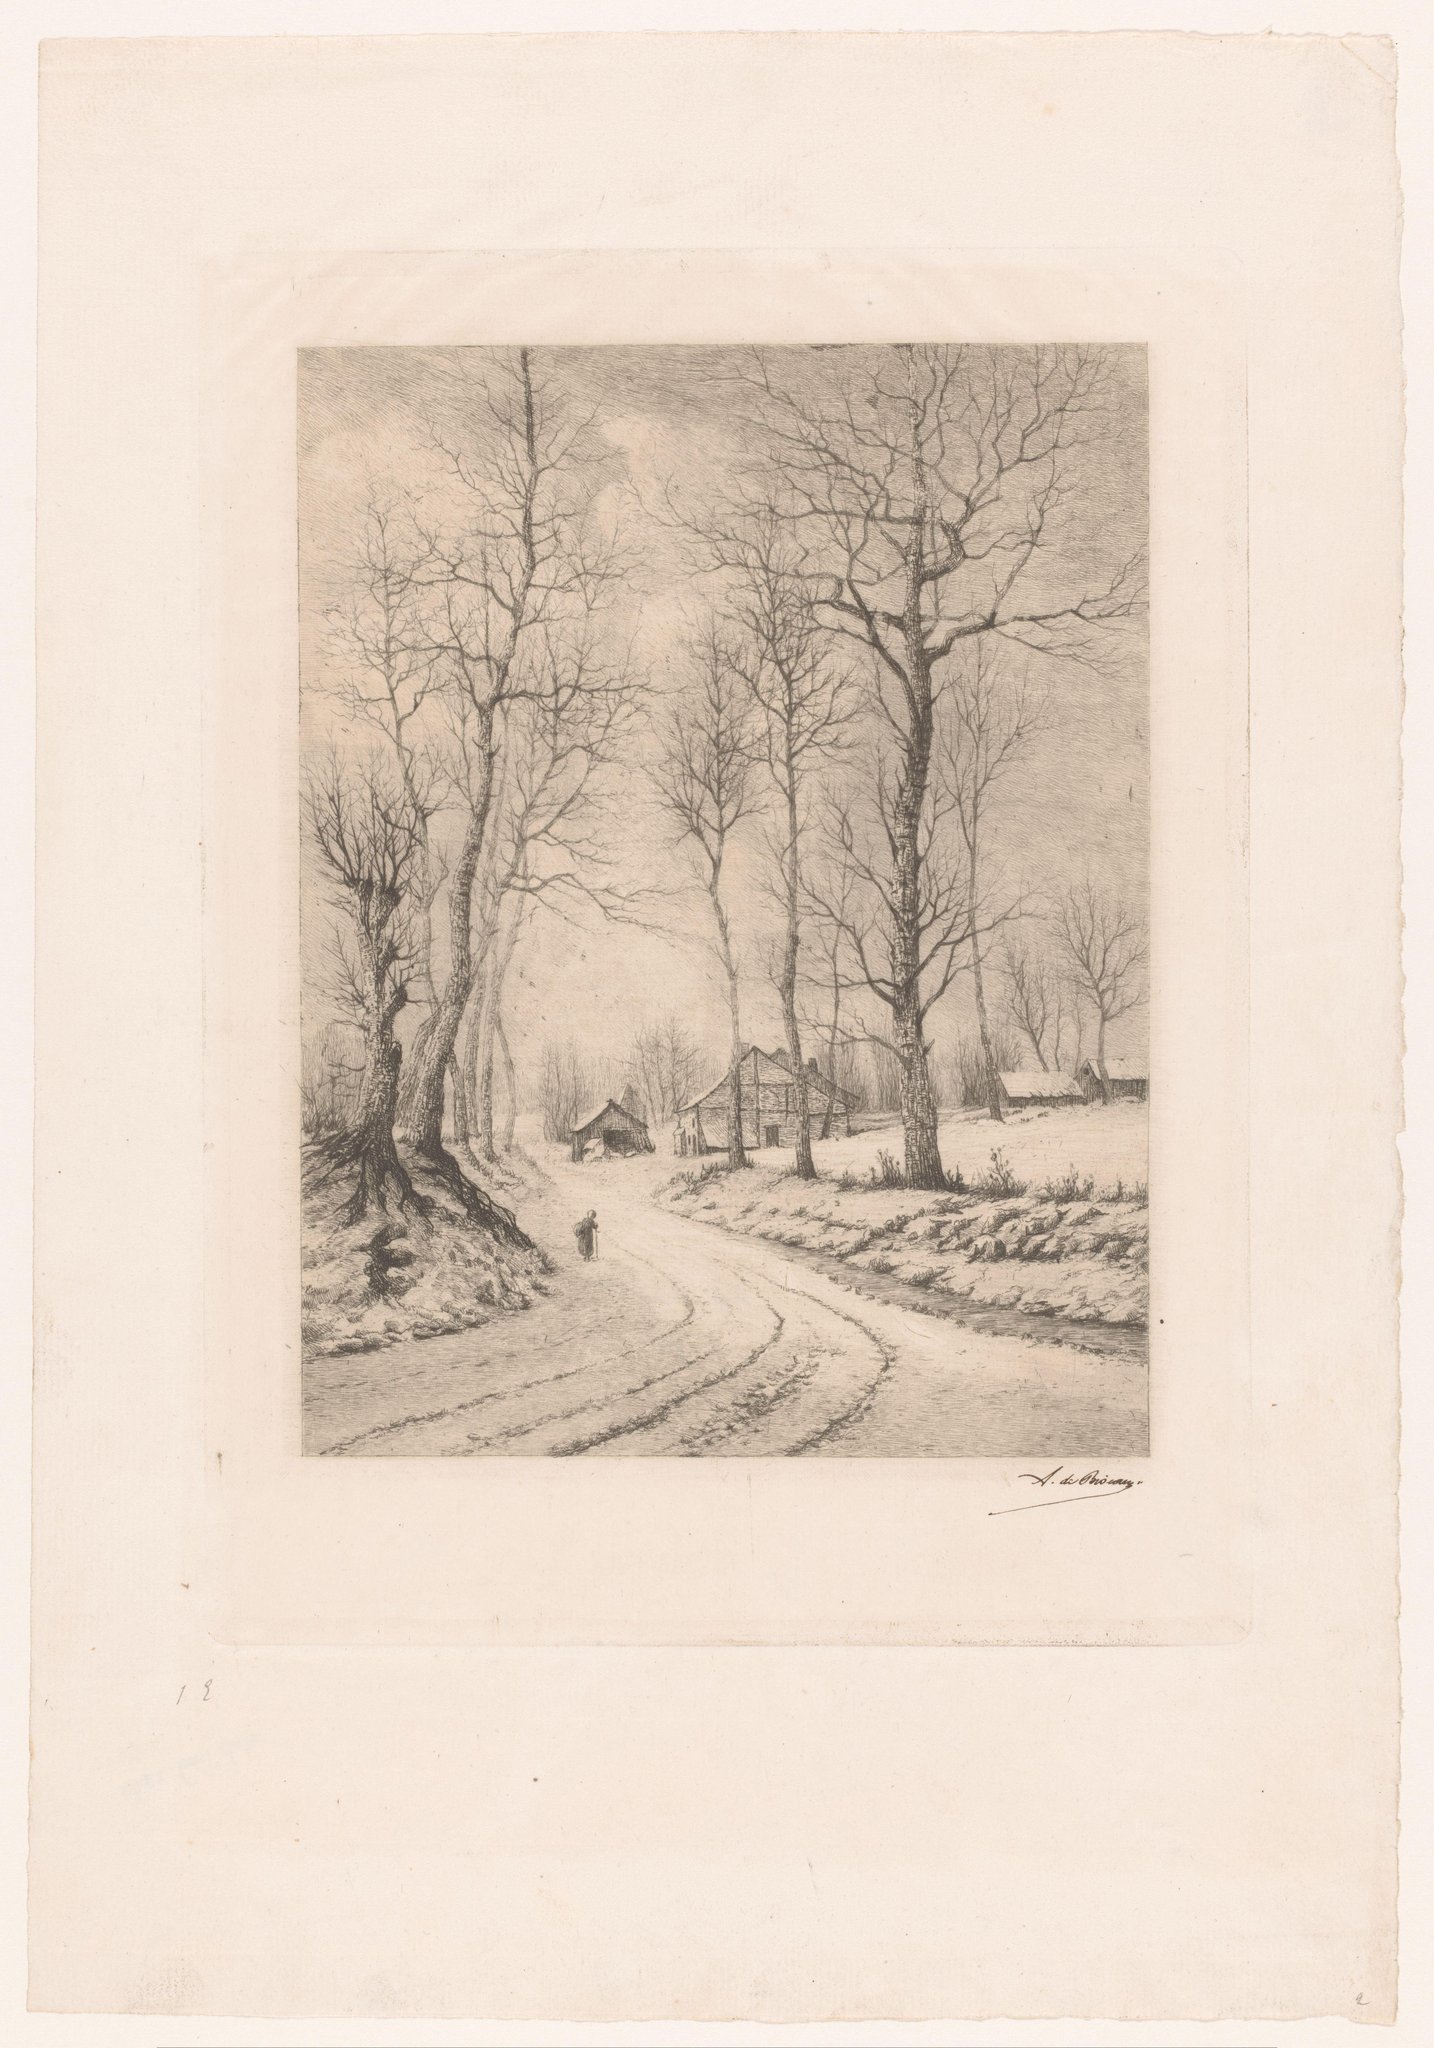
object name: print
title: Hiver à Auderghem (Belgique)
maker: aristide de biseau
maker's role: print maker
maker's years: 1844-1883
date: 1854-1883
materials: paper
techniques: etching, intaglio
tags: forest path or lane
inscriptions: collector's mark: Lugt 2228